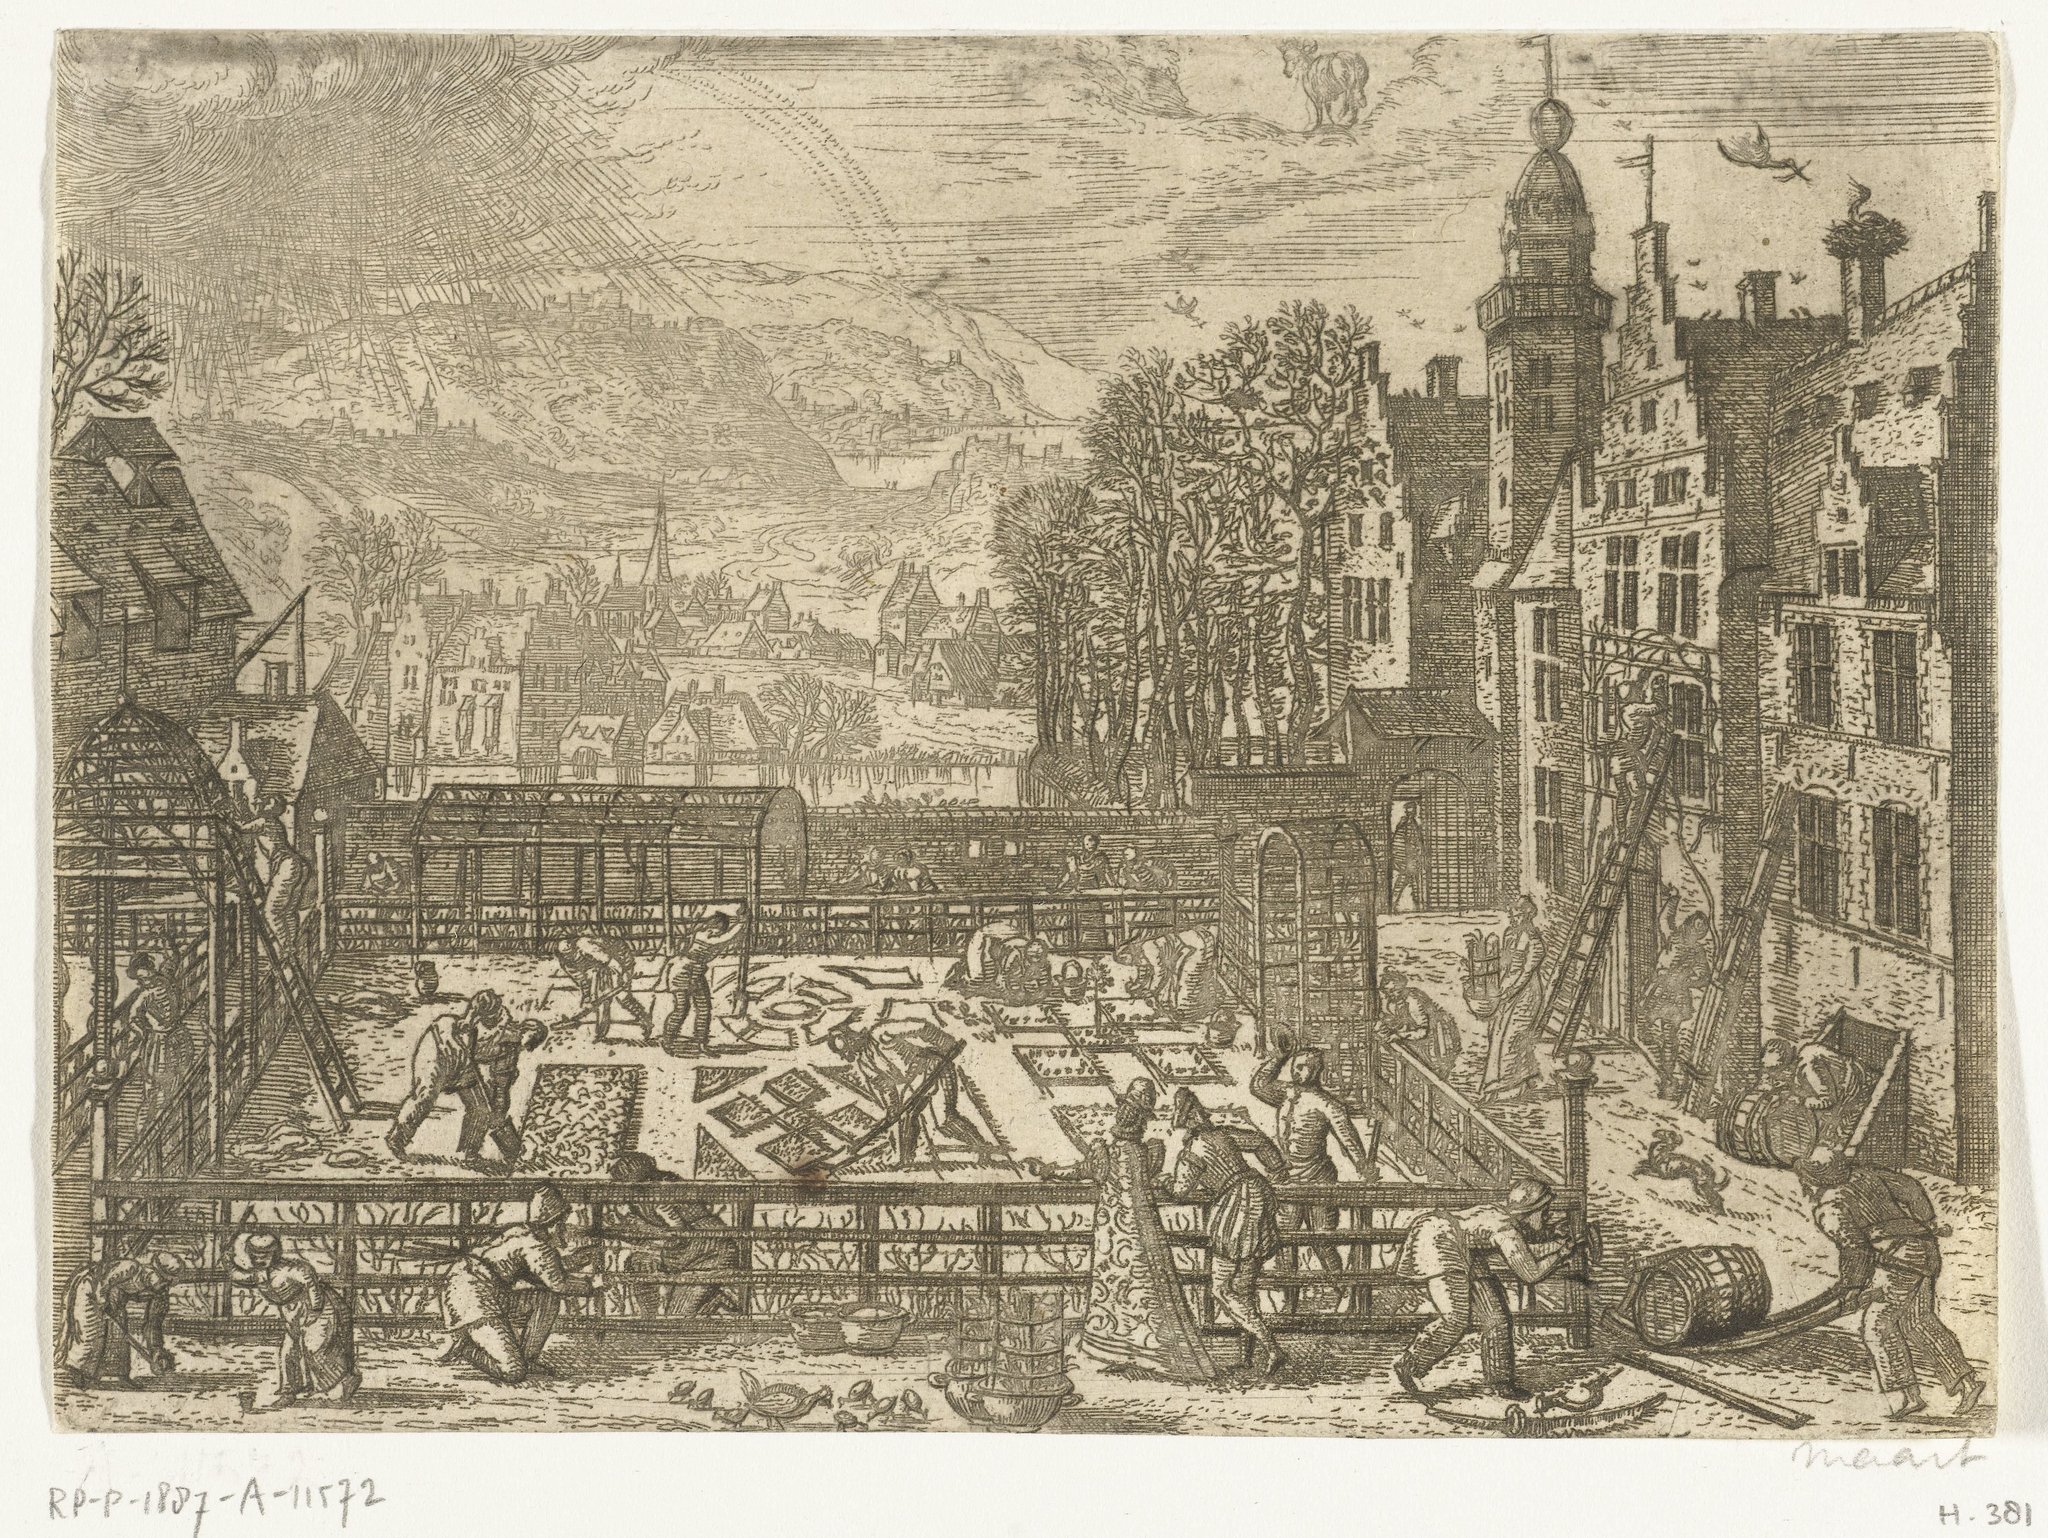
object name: print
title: De twaalf maanden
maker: pieter van der borcht (i)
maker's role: print maker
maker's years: 1545-1608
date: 1545-1608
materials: paper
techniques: etching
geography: antwerp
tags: french or architectonic garden; formal garden, slipping, grafting, cutting of plants, sowing, march and its 'labours' (+ with zodiacal signs), pruning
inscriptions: collector's mark: Lugt 2228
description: Lentelandschap met voorjaarstaferelen. Maart in de plantmaand. Overal zijn mensen in de weer met het aanleggen van een tuin. Men plant, zaait, snoeit, ent en legt perkjes aan. Verder worden de bier- en wijnkelders opnieuw aangevuld. Middenboven het sterrenbeeld Ram. In deze serie van de twaalf maanden wordt elke maand afgebeeld met de voor haar typerende menselijke activiteiten, haar klimatologische kenmerken en haar sterrenbeeld.